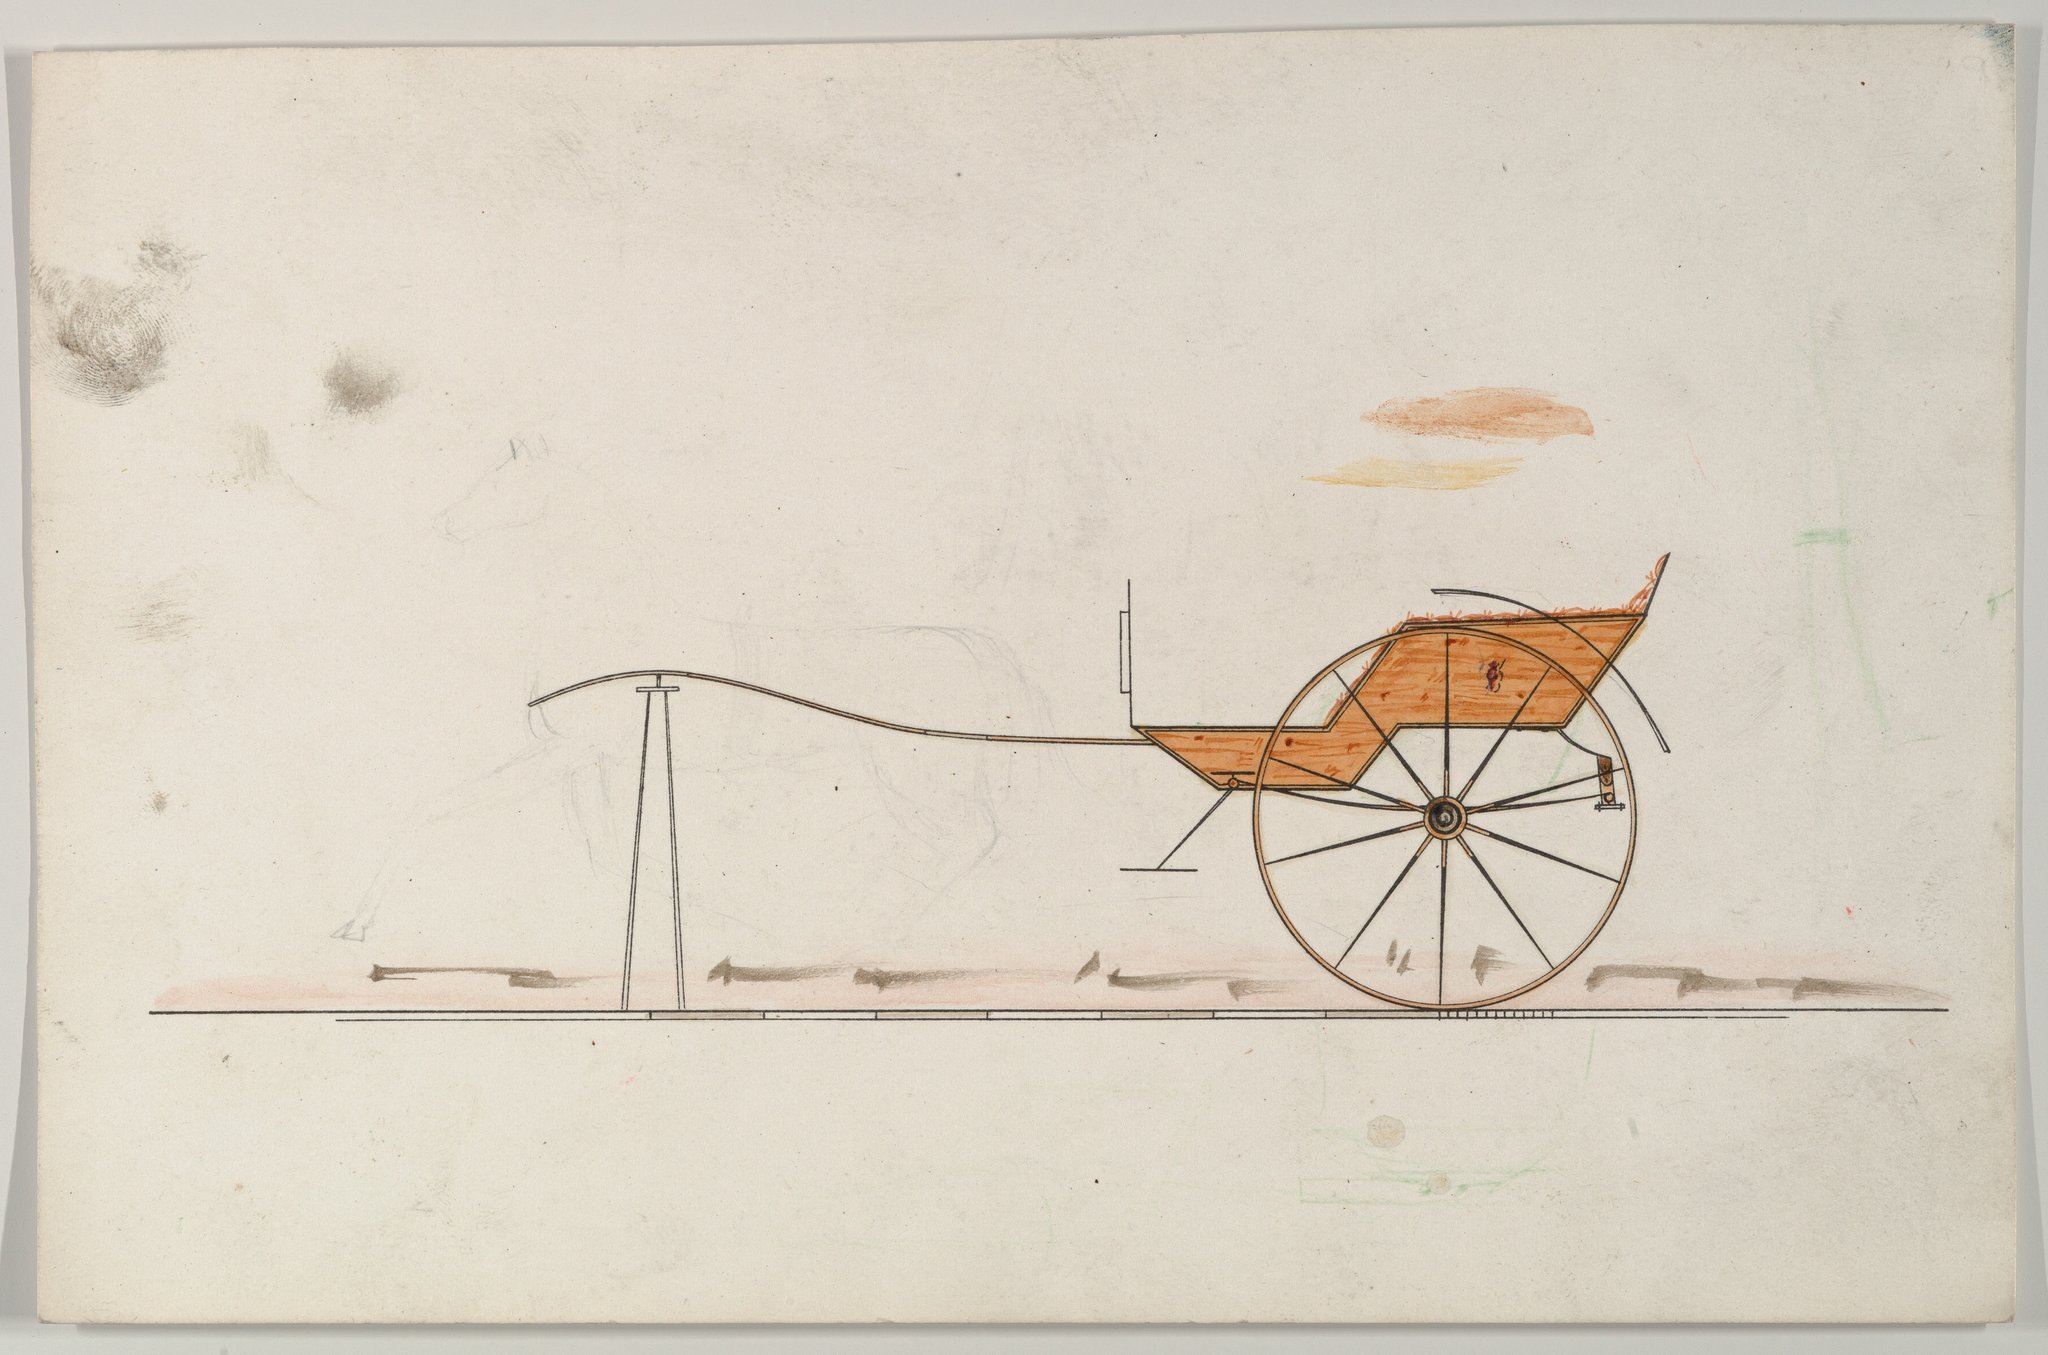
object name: drawing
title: Cart/Gig (unnumbered)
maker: brewster & co.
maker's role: manufacturer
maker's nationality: american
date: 1850-1874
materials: gouache, graphite, gum arabic, ink, watercolor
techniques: pen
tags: carriages